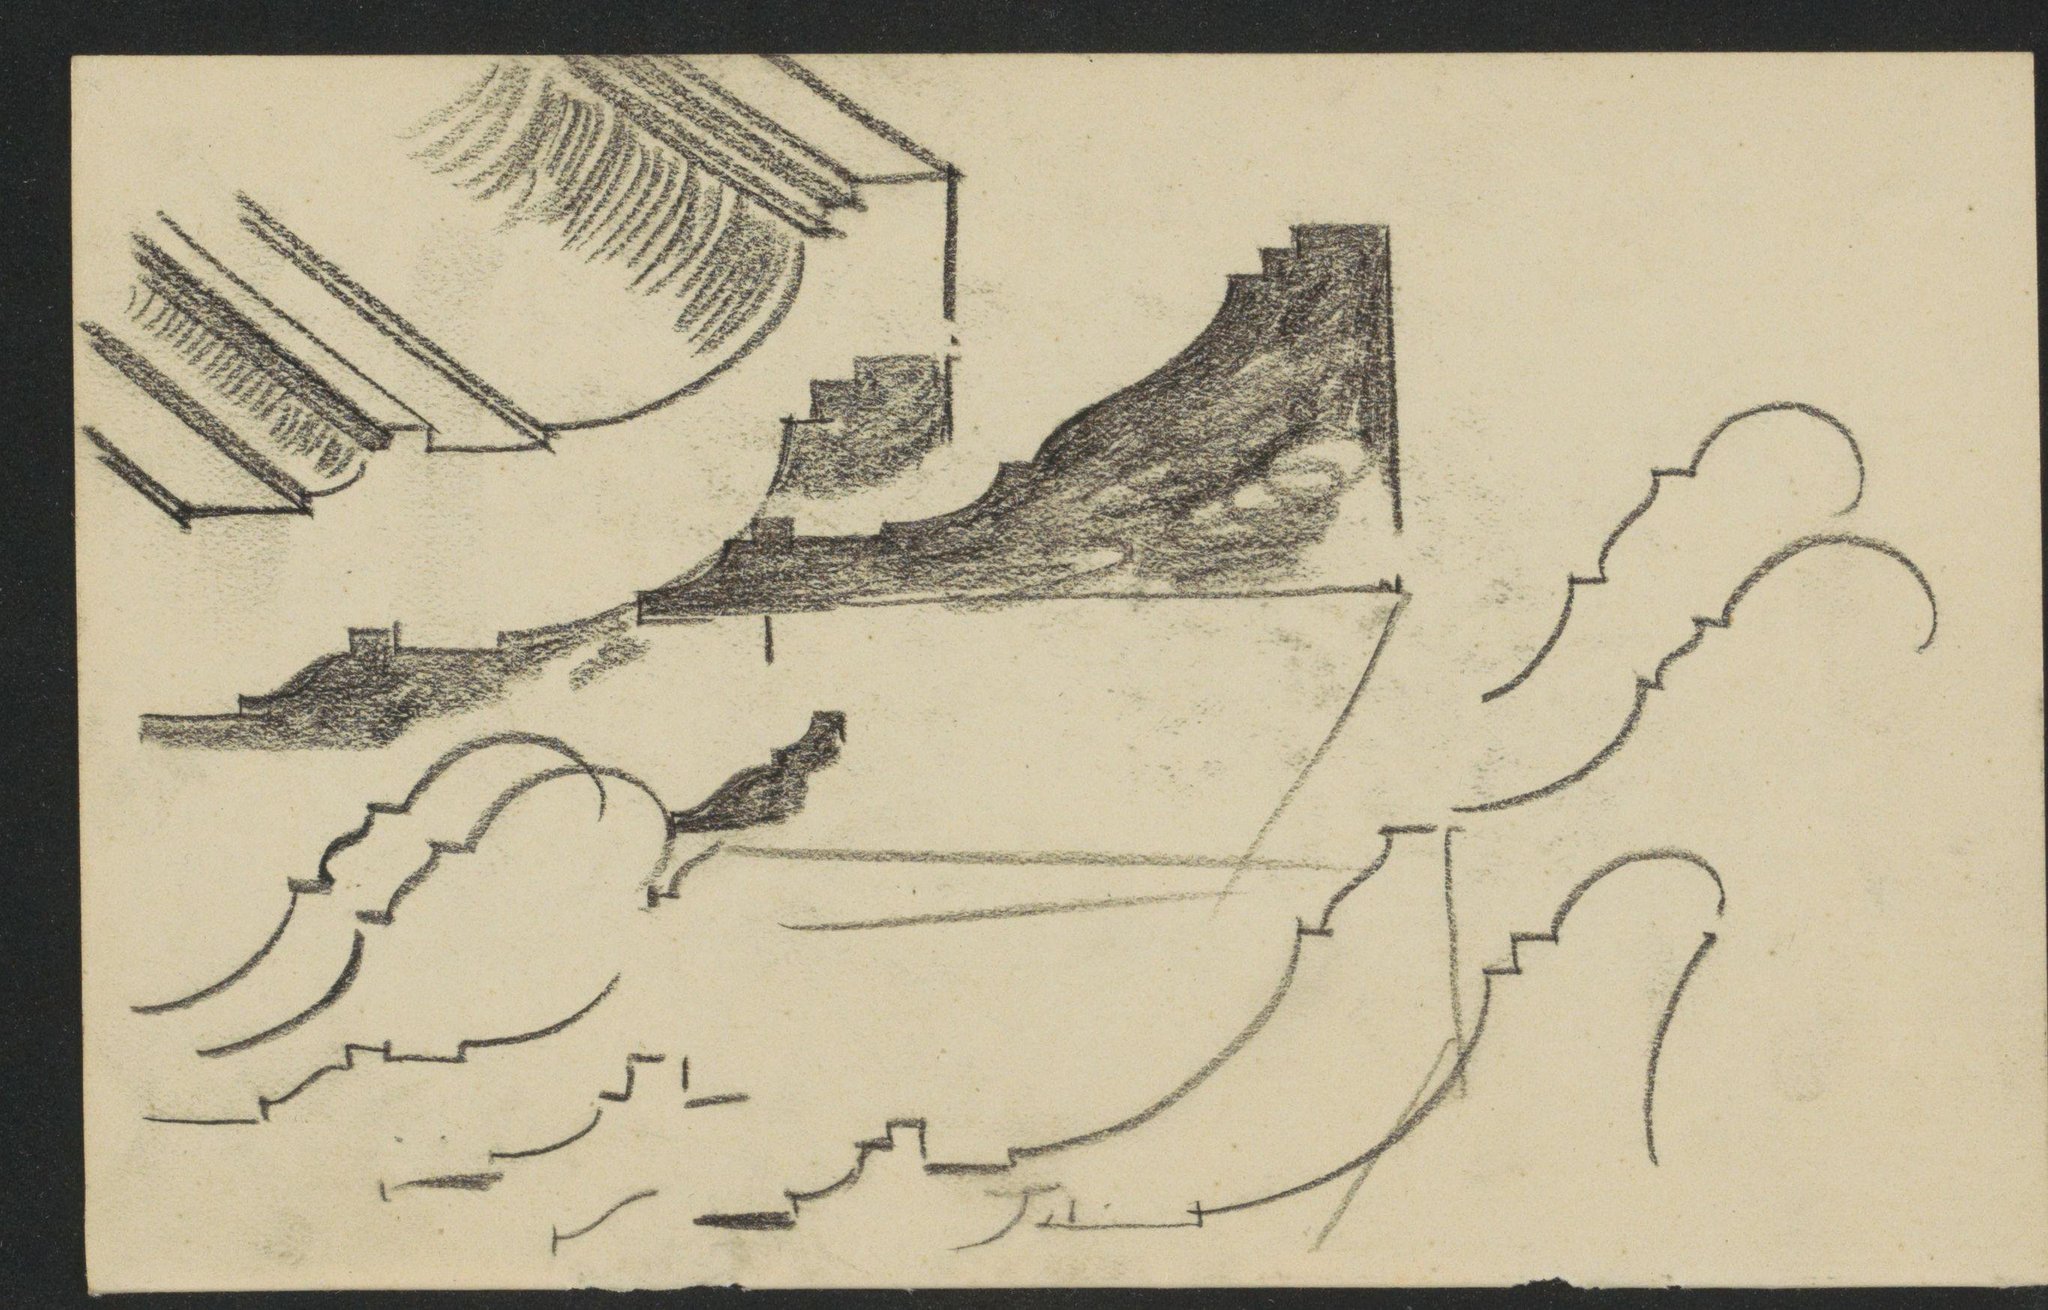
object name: drawing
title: Doorsnede van een lijst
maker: gerrit willem dijsselhof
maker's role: designer, draughtsman, print maker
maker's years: 1866-1924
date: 1876-1924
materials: chalk, paper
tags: frame of painting, etc.